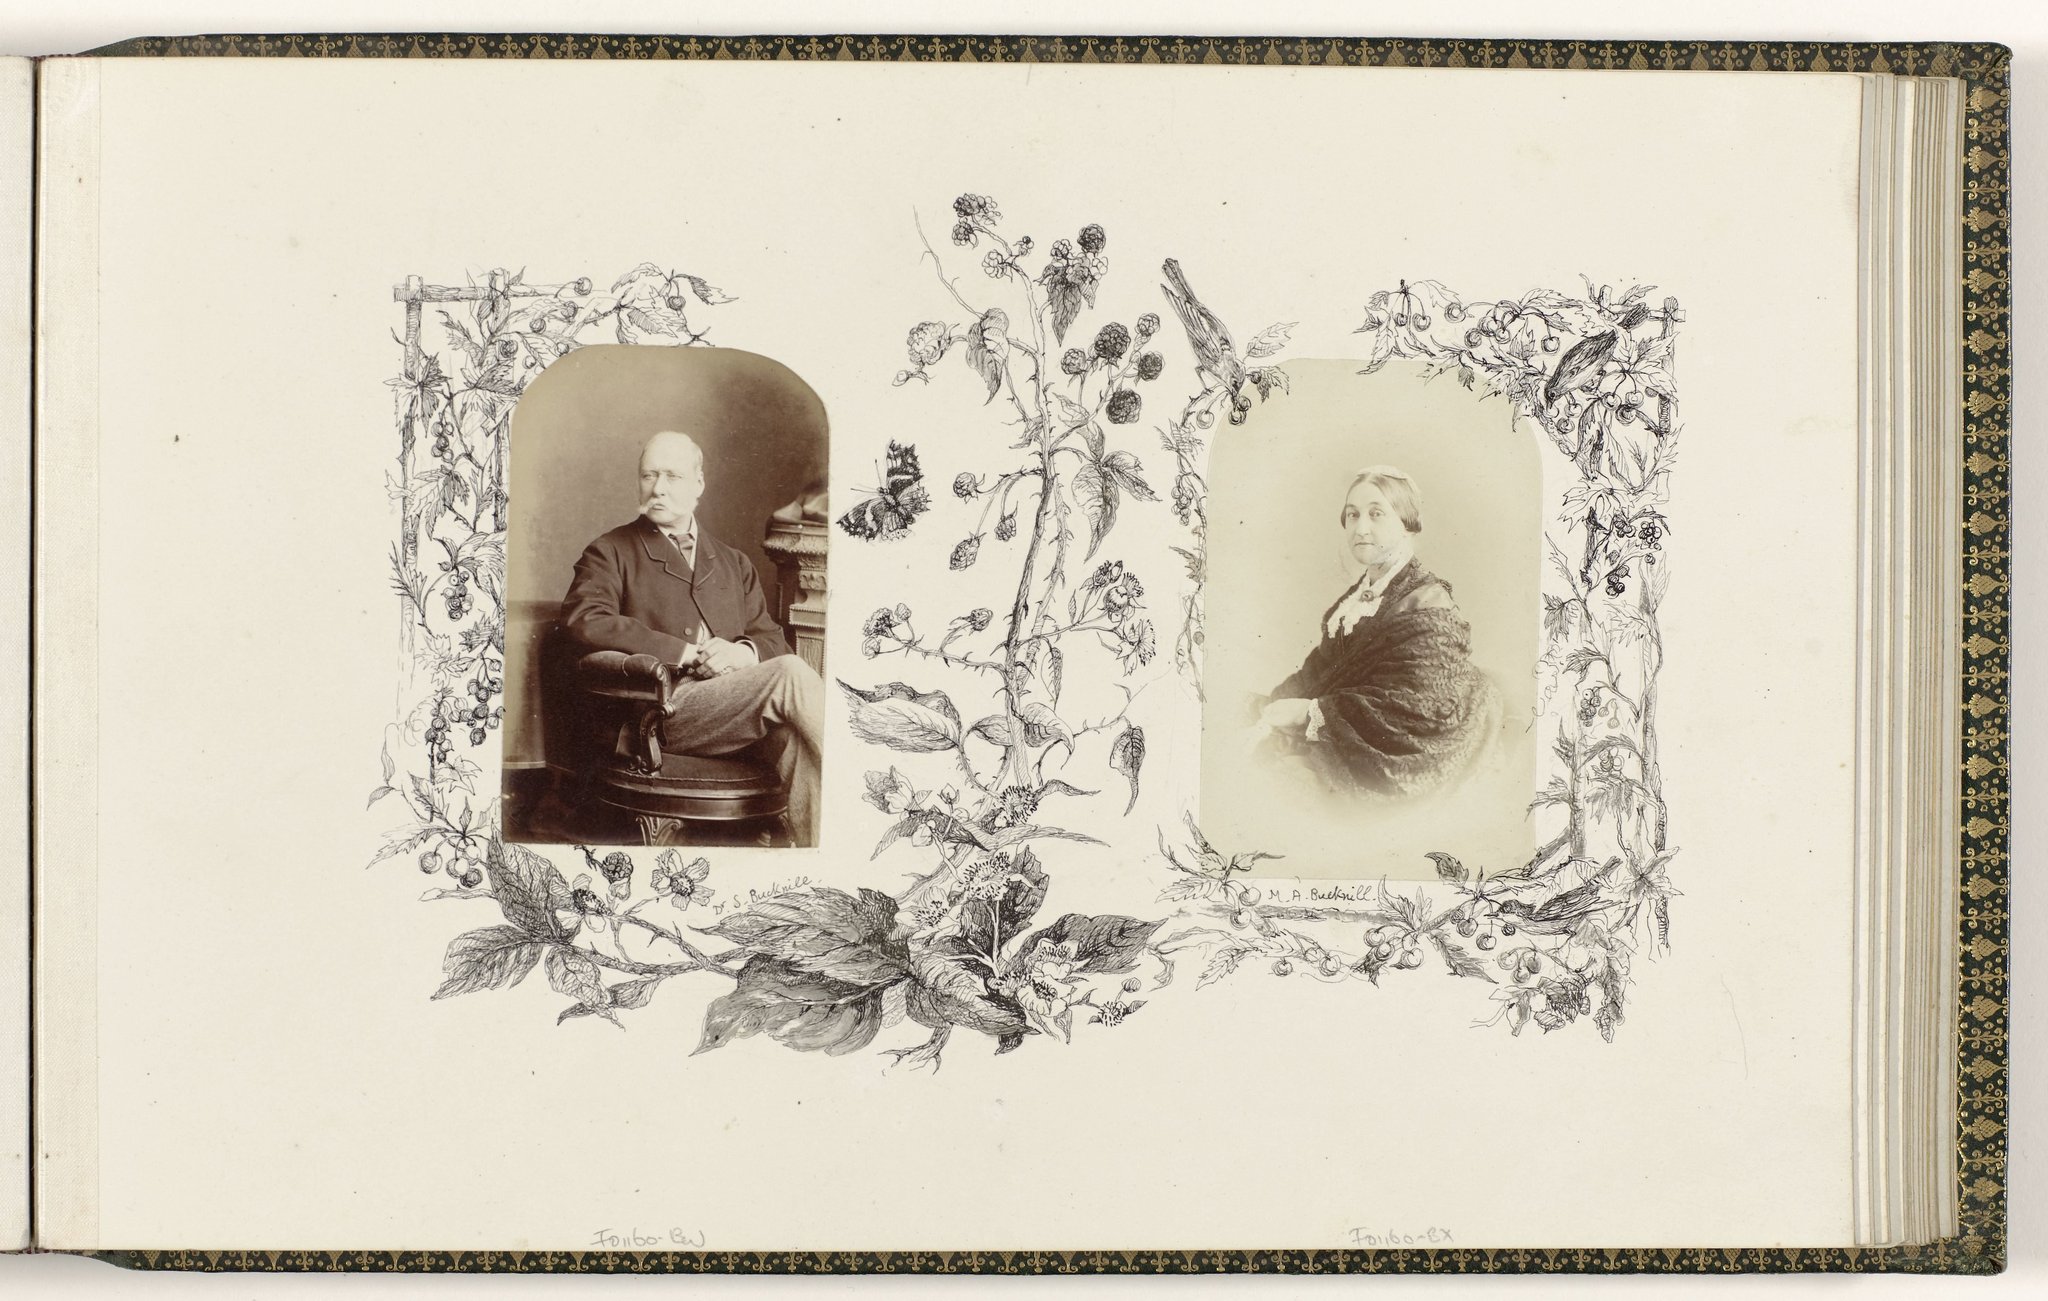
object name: photograph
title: Portret van een onbekende vrouw, aangeduid als M.A. Bucknile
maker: Anonymous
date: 1870-1880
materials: paper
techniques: albumen print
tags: historical persons - bb - woman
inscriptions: inscription: ‘M.A. Bucknile’